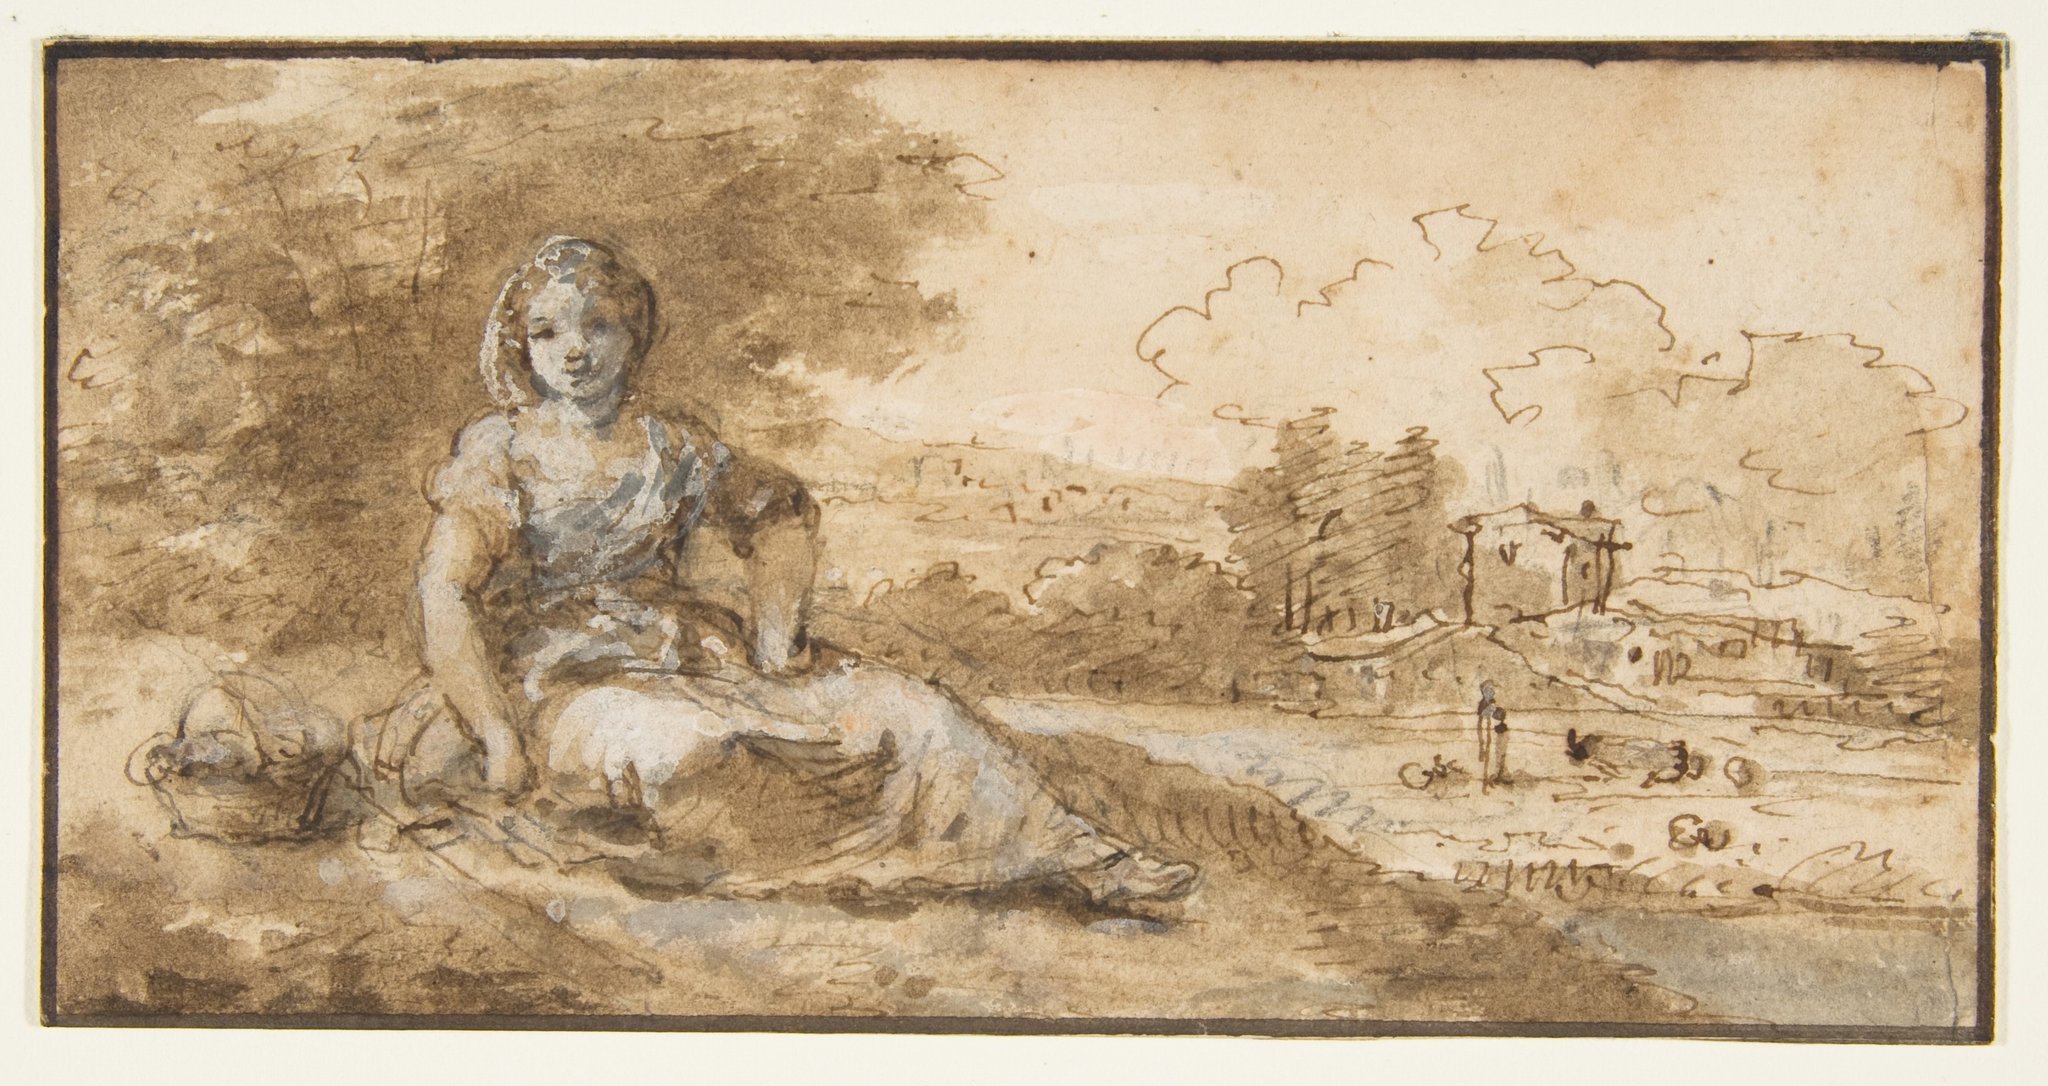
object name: drawing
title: Seated Girl in a Landscape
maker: francesco zuccarelli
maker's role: artist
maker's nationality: italian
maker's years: 1702-1788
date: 1702-1788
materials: gouache, graphite, ink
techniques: brush, highlighting, pen, wash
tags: houses,girls,landscapes